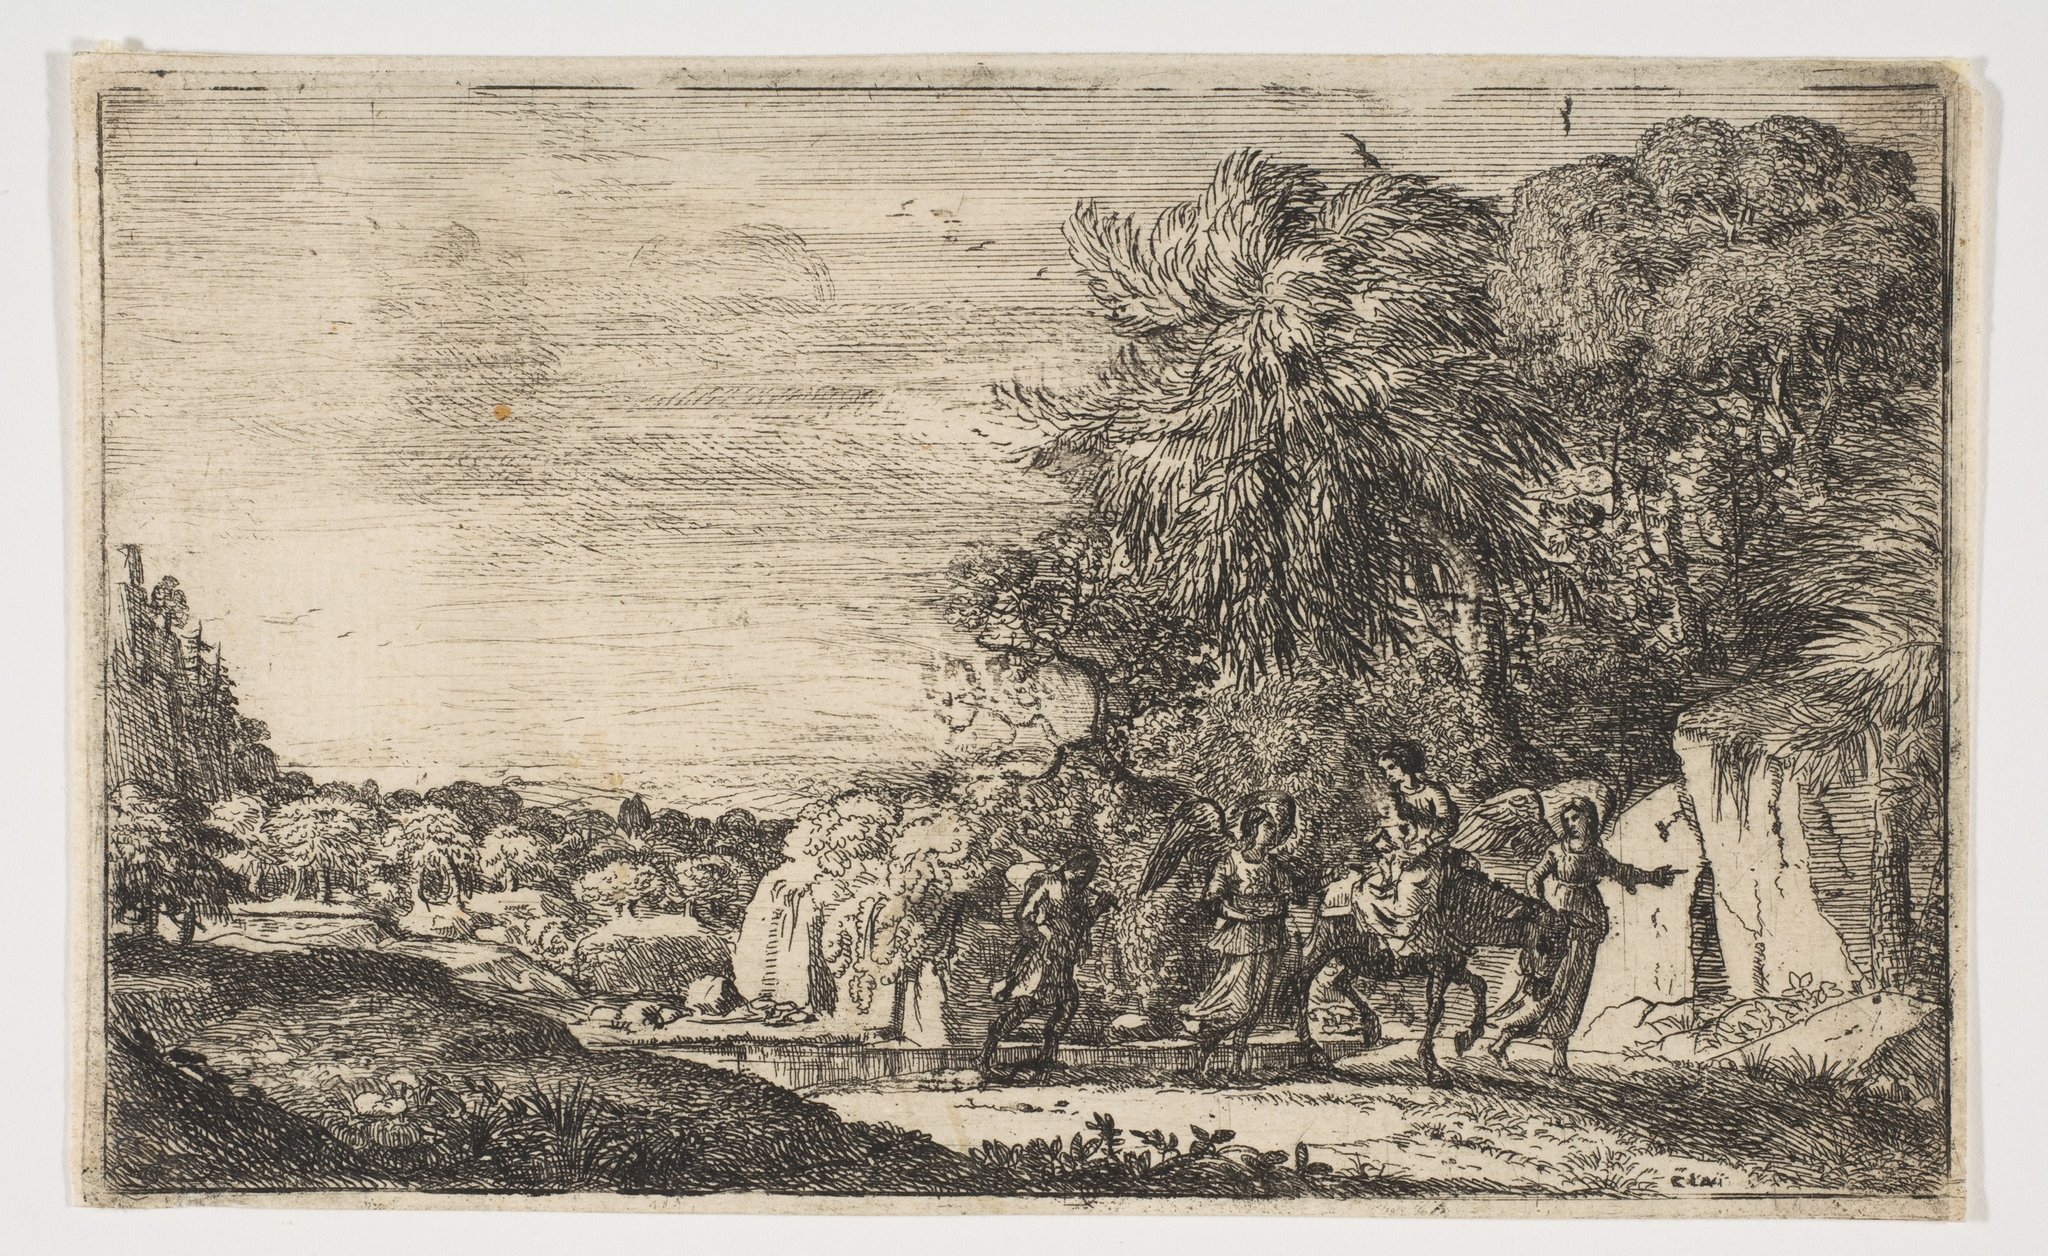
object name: print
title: The Flight into Egypt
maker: claude lorrain (claude gellée)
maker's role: artist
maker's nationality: french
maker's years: 1604-1682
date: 1630-1631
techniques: etching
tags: human figures,horses,trees,angels